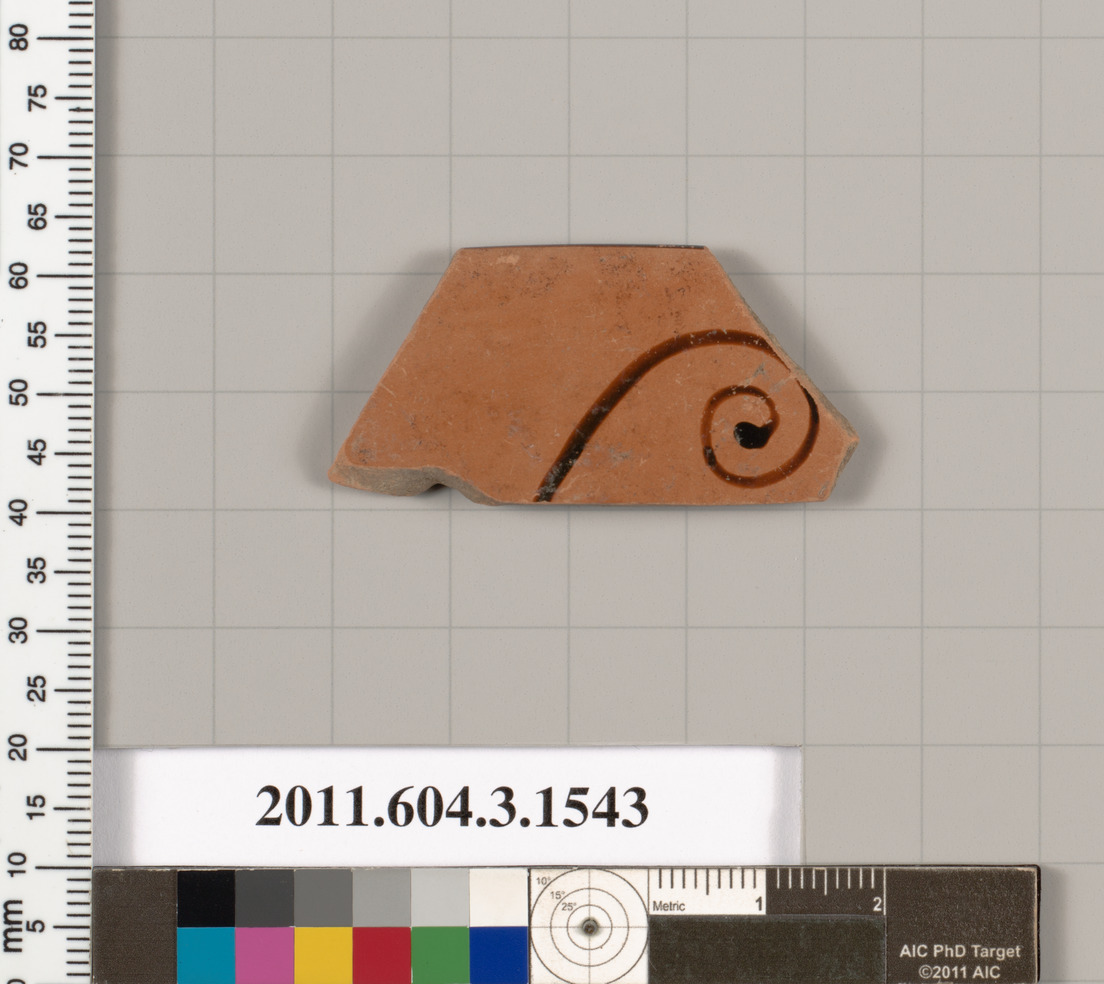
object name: kylix fragment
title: Terracotta rim fragment of a kylix (drinking cup)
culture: greek, attic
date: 550-526 BCE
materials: terracotta